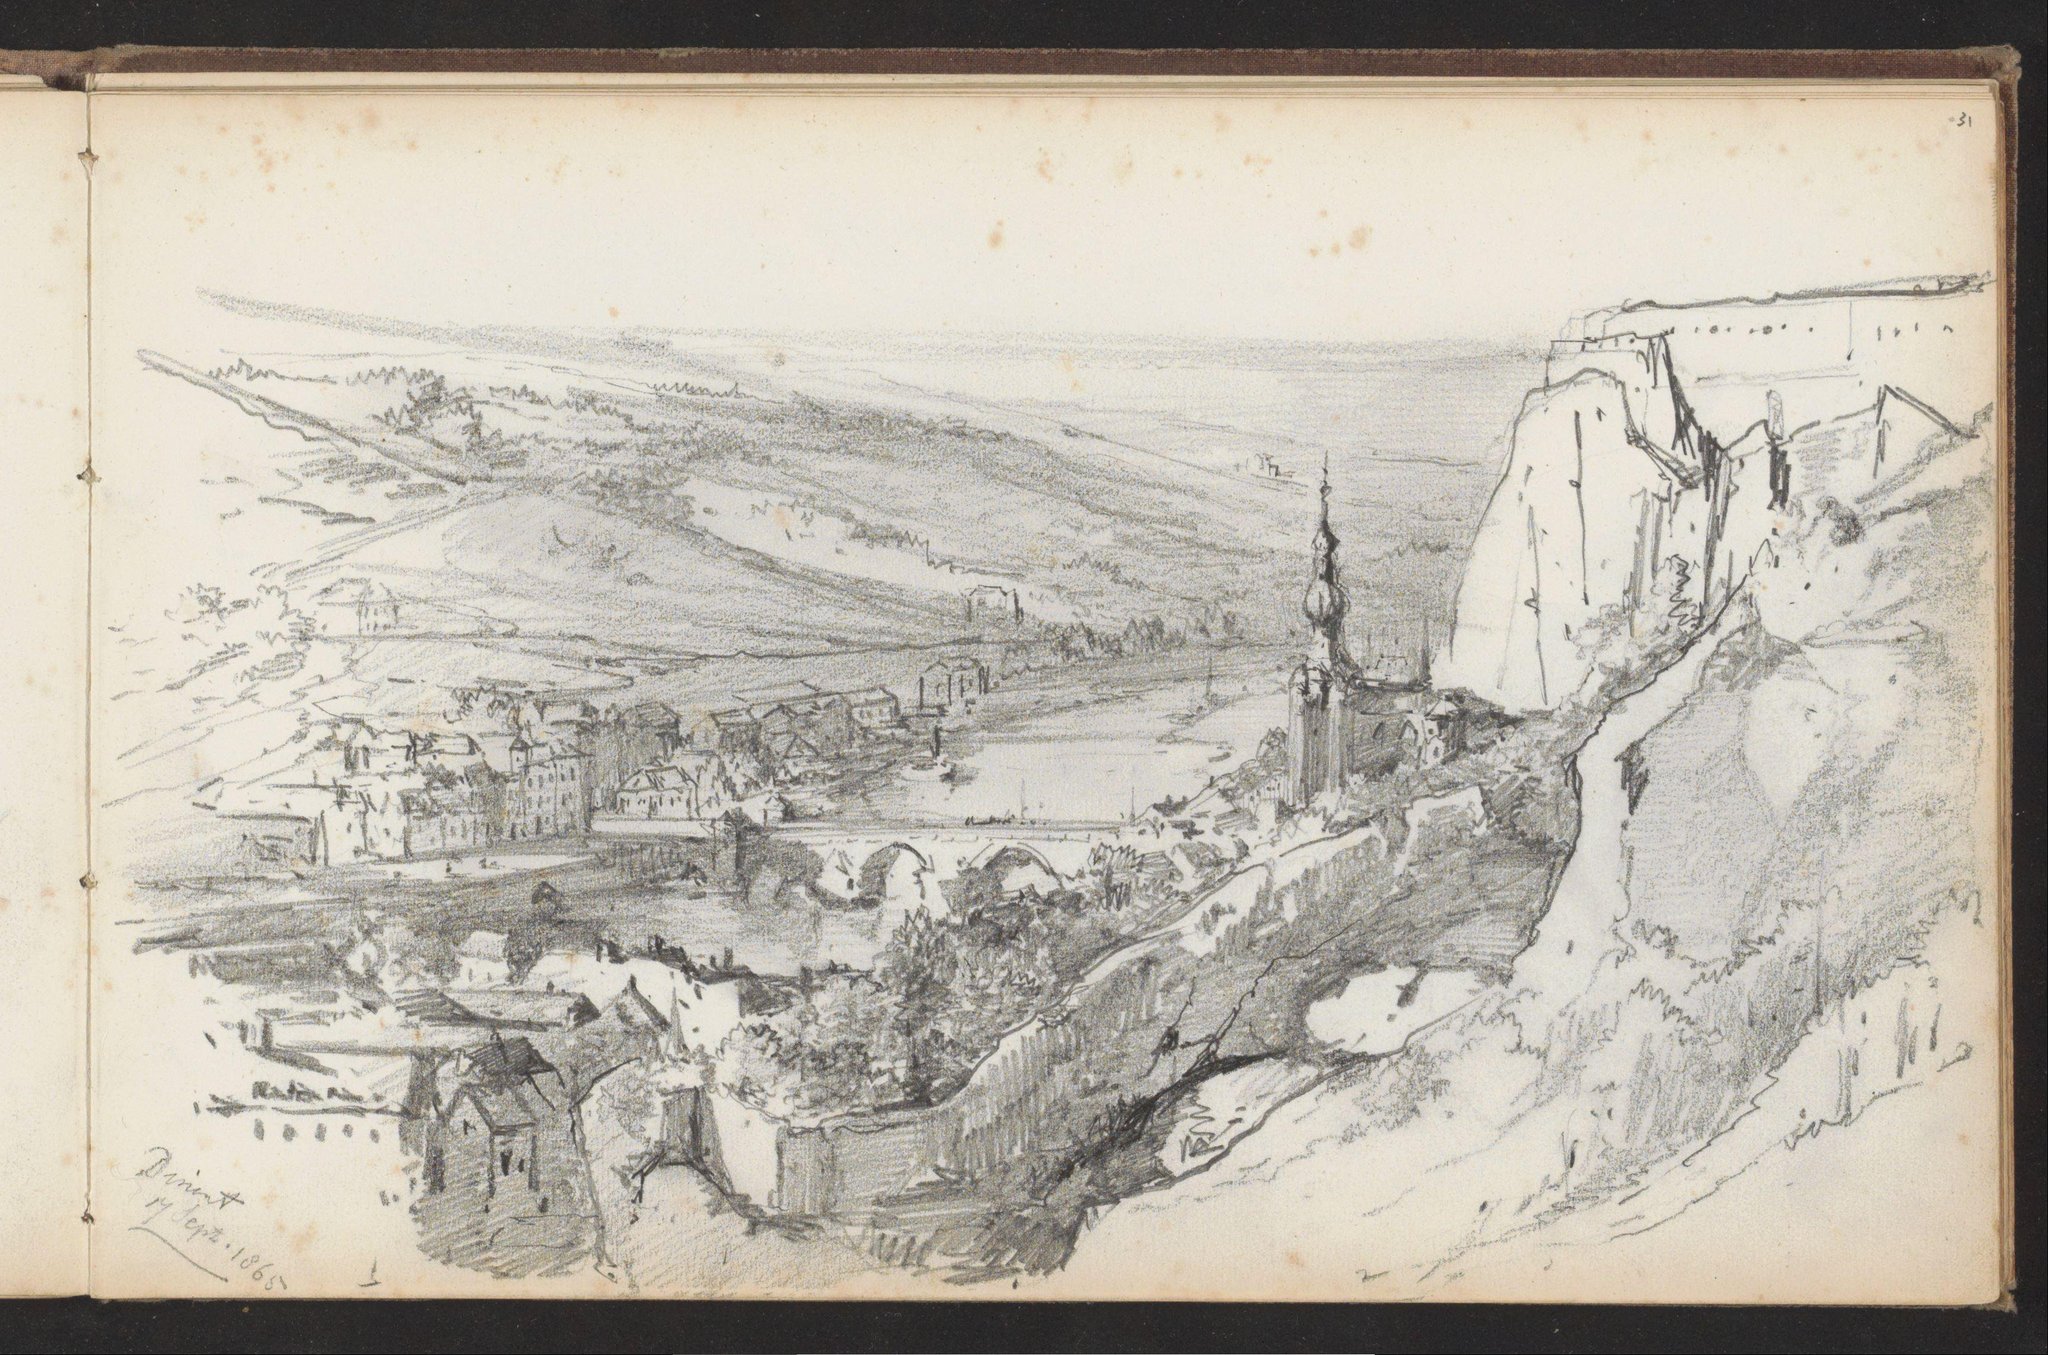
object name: sketchbook leaf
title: Gezicht op Dinant aan de Maas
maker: maria vos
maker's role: draughtsman, painter, print maker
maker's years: 1824-1906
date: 1809-1865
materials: paper, pencil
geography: dinant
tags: city-view, and landscape with man-made constructions, landscapes with waters, waterscapes, seascapes (in the temperate zone)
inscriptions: date and inscription: ‘Dinant/ 17 Sept. 1865’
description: Blad 31 recto uit een schetsboek met 55 bladen.